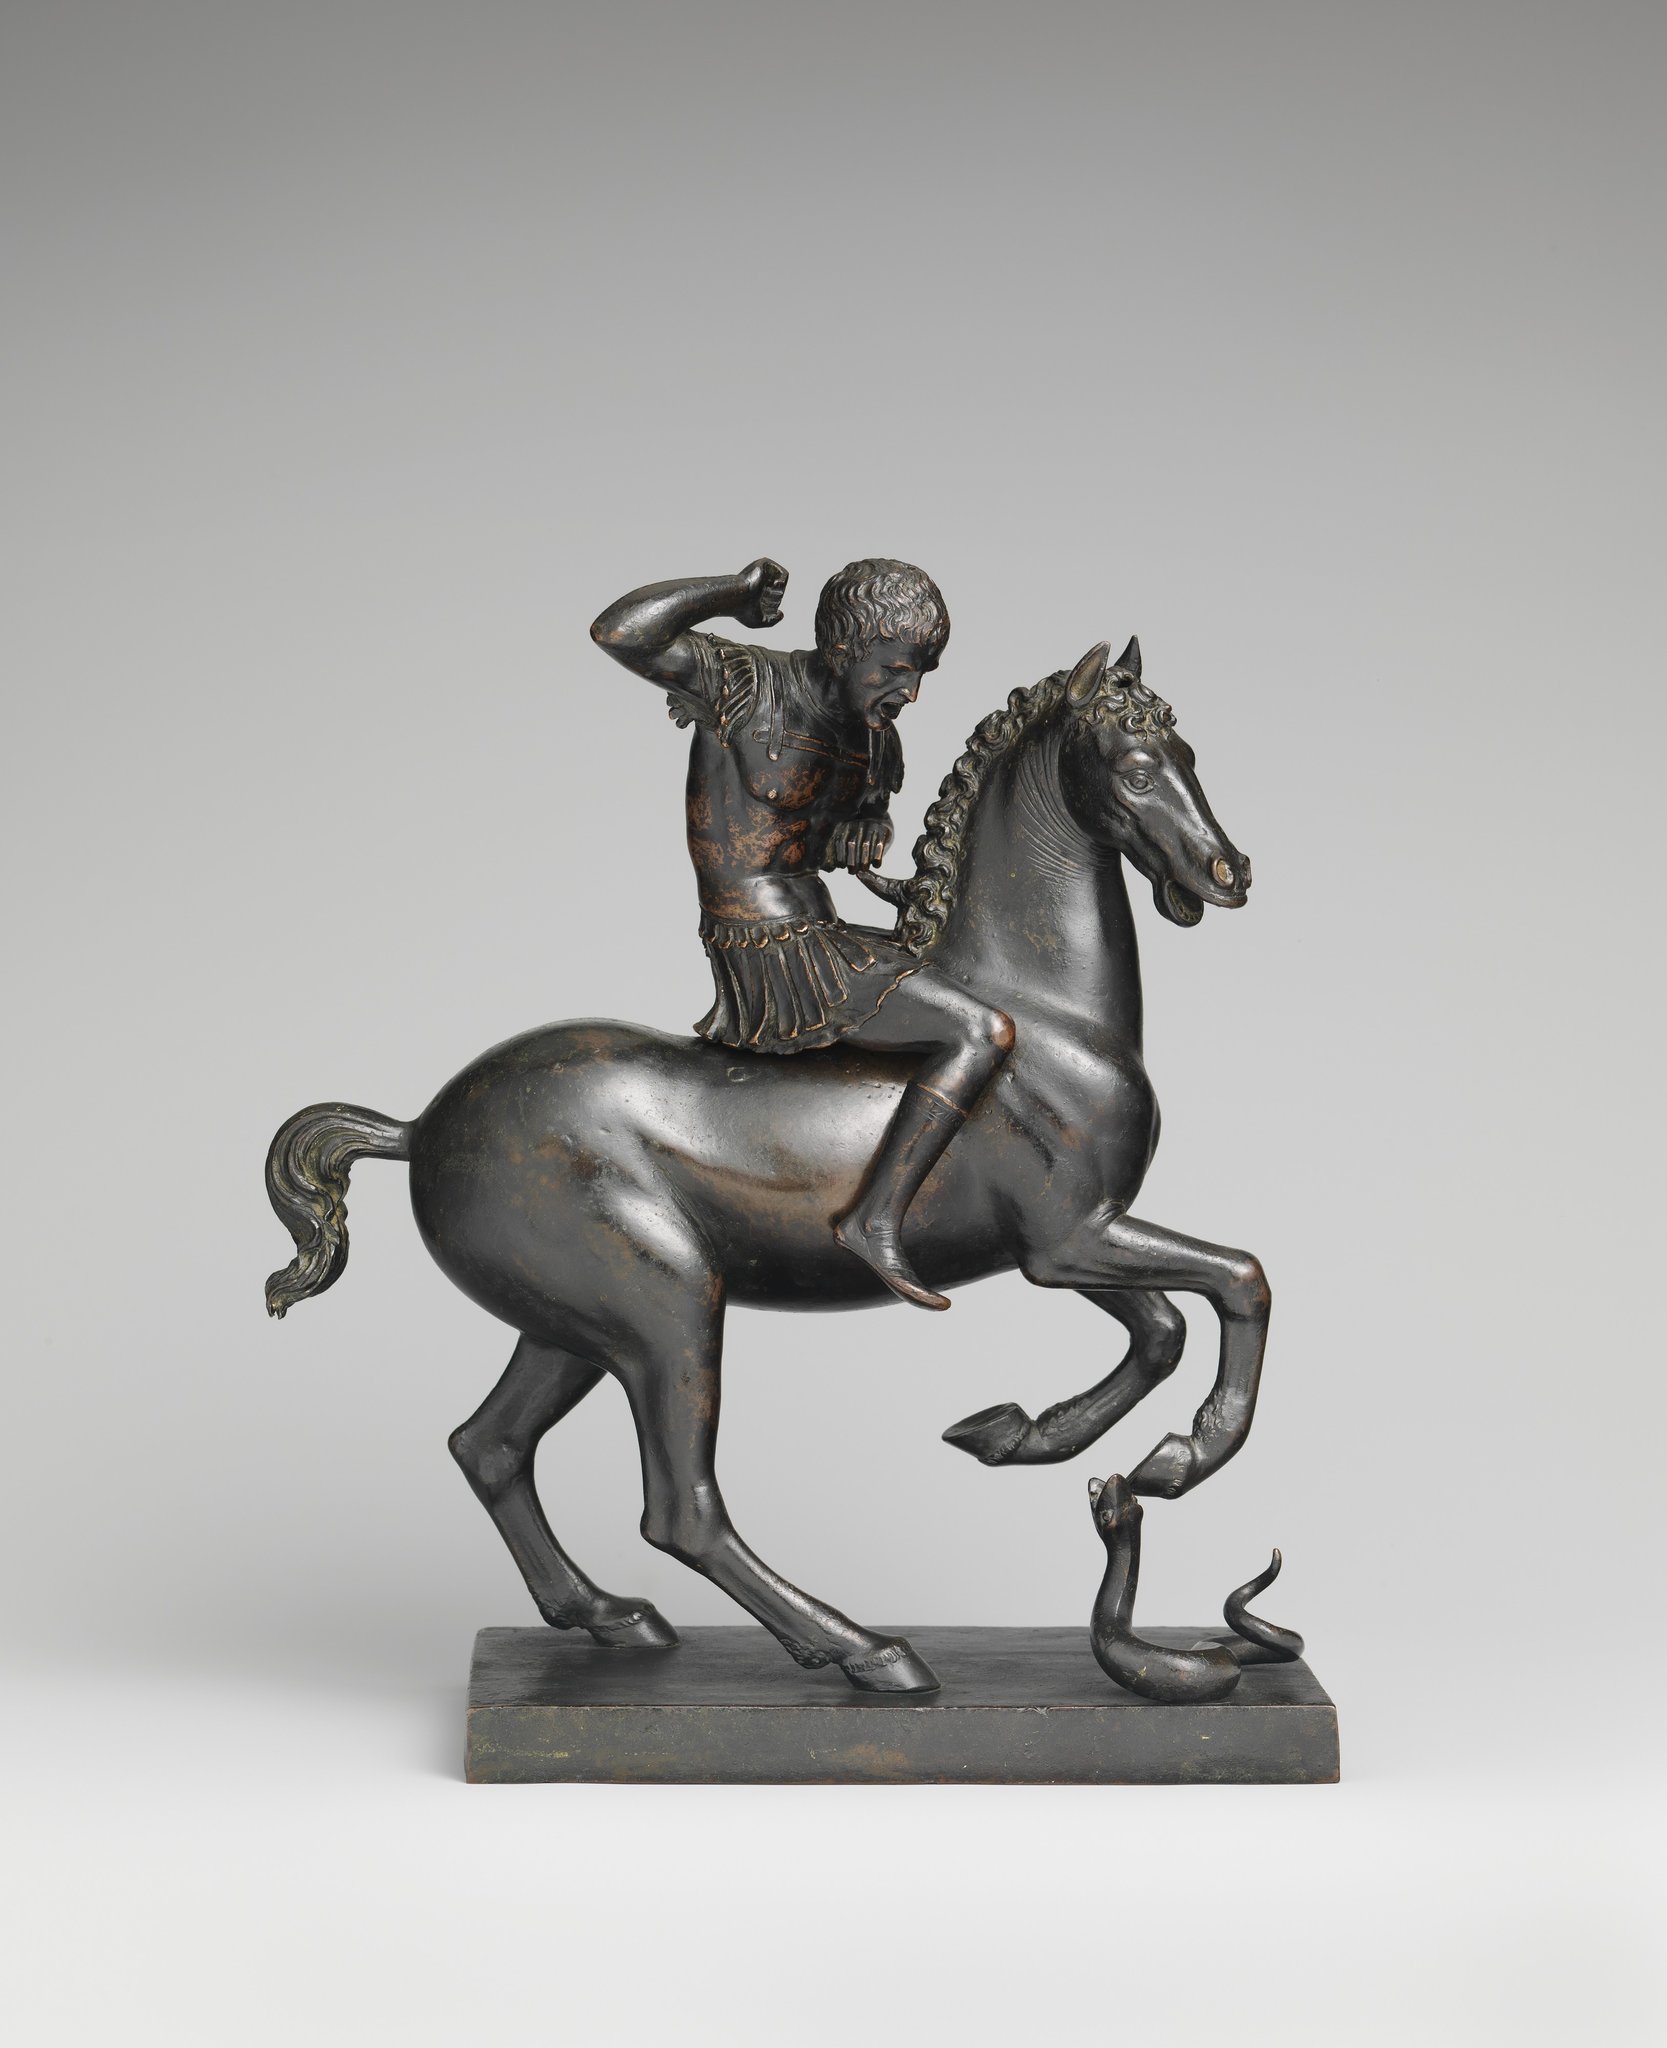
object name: statuette group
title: Horse and rider startled by a snake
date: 1501-1533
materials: bronze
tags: men,horses,snakes